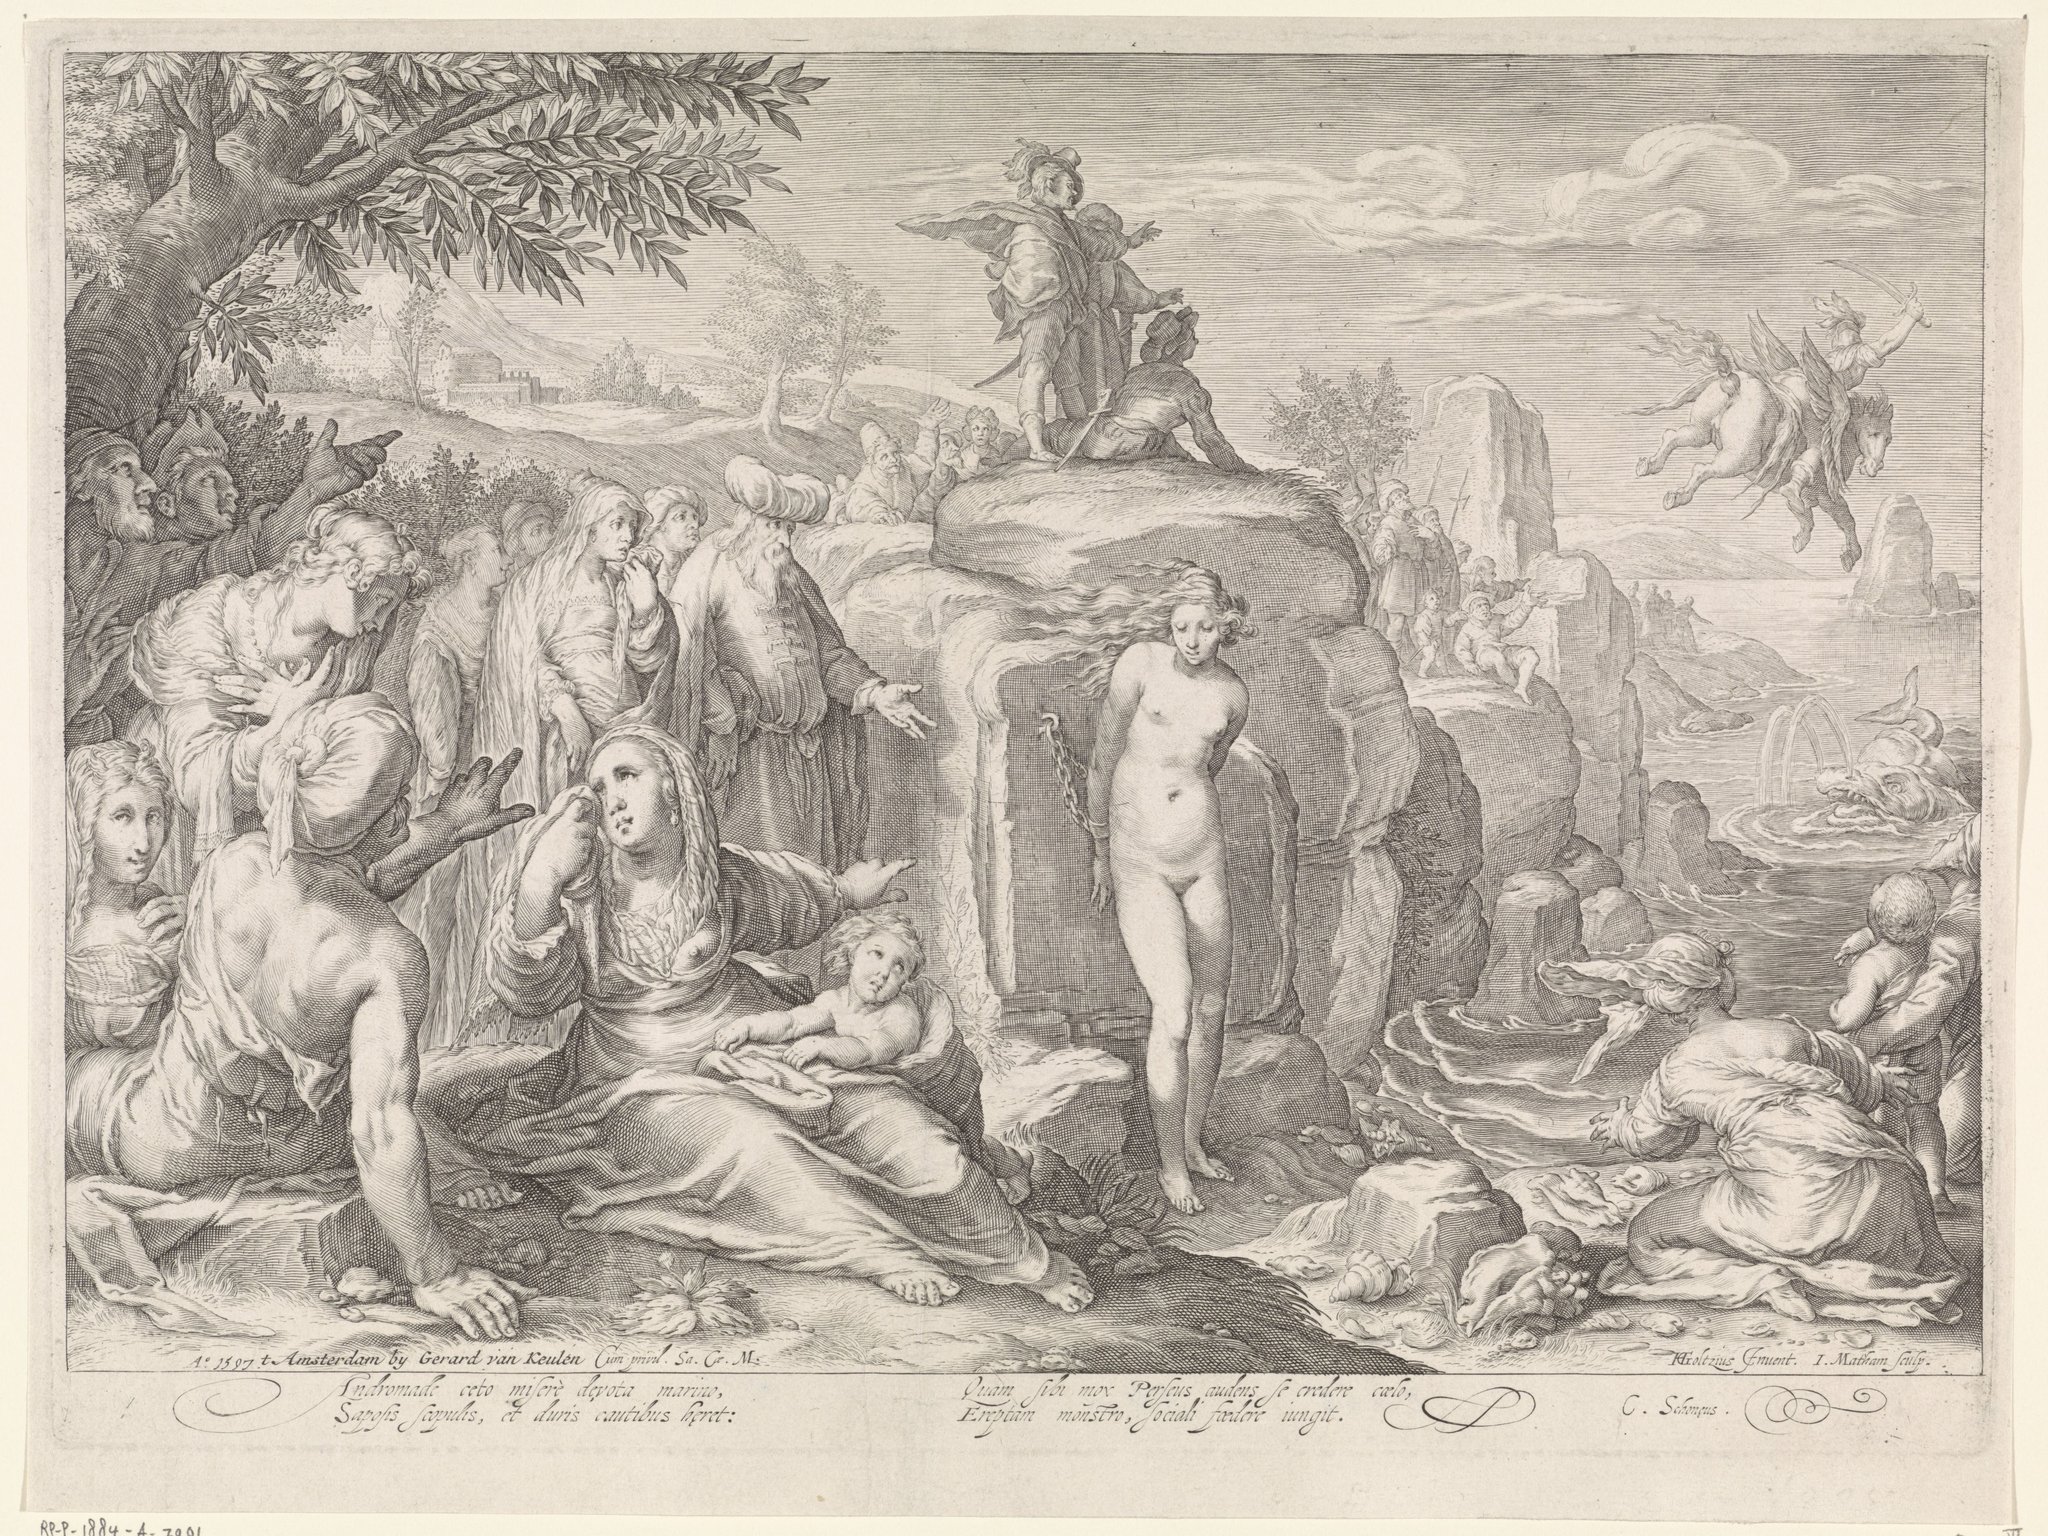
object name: print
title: Andromeda aan de rots geketend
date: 1597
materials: paper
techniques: engraving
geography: amsterdam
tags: perseus and andromeda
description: Andromeda is aan een rots geketend, als offer aan een zeemonster, dat rechts in het water ligt. Daarboven vliegt Perseus, klaar om het monster te doden. De ouders van Andromeda en omstanders treuren en wijzen.